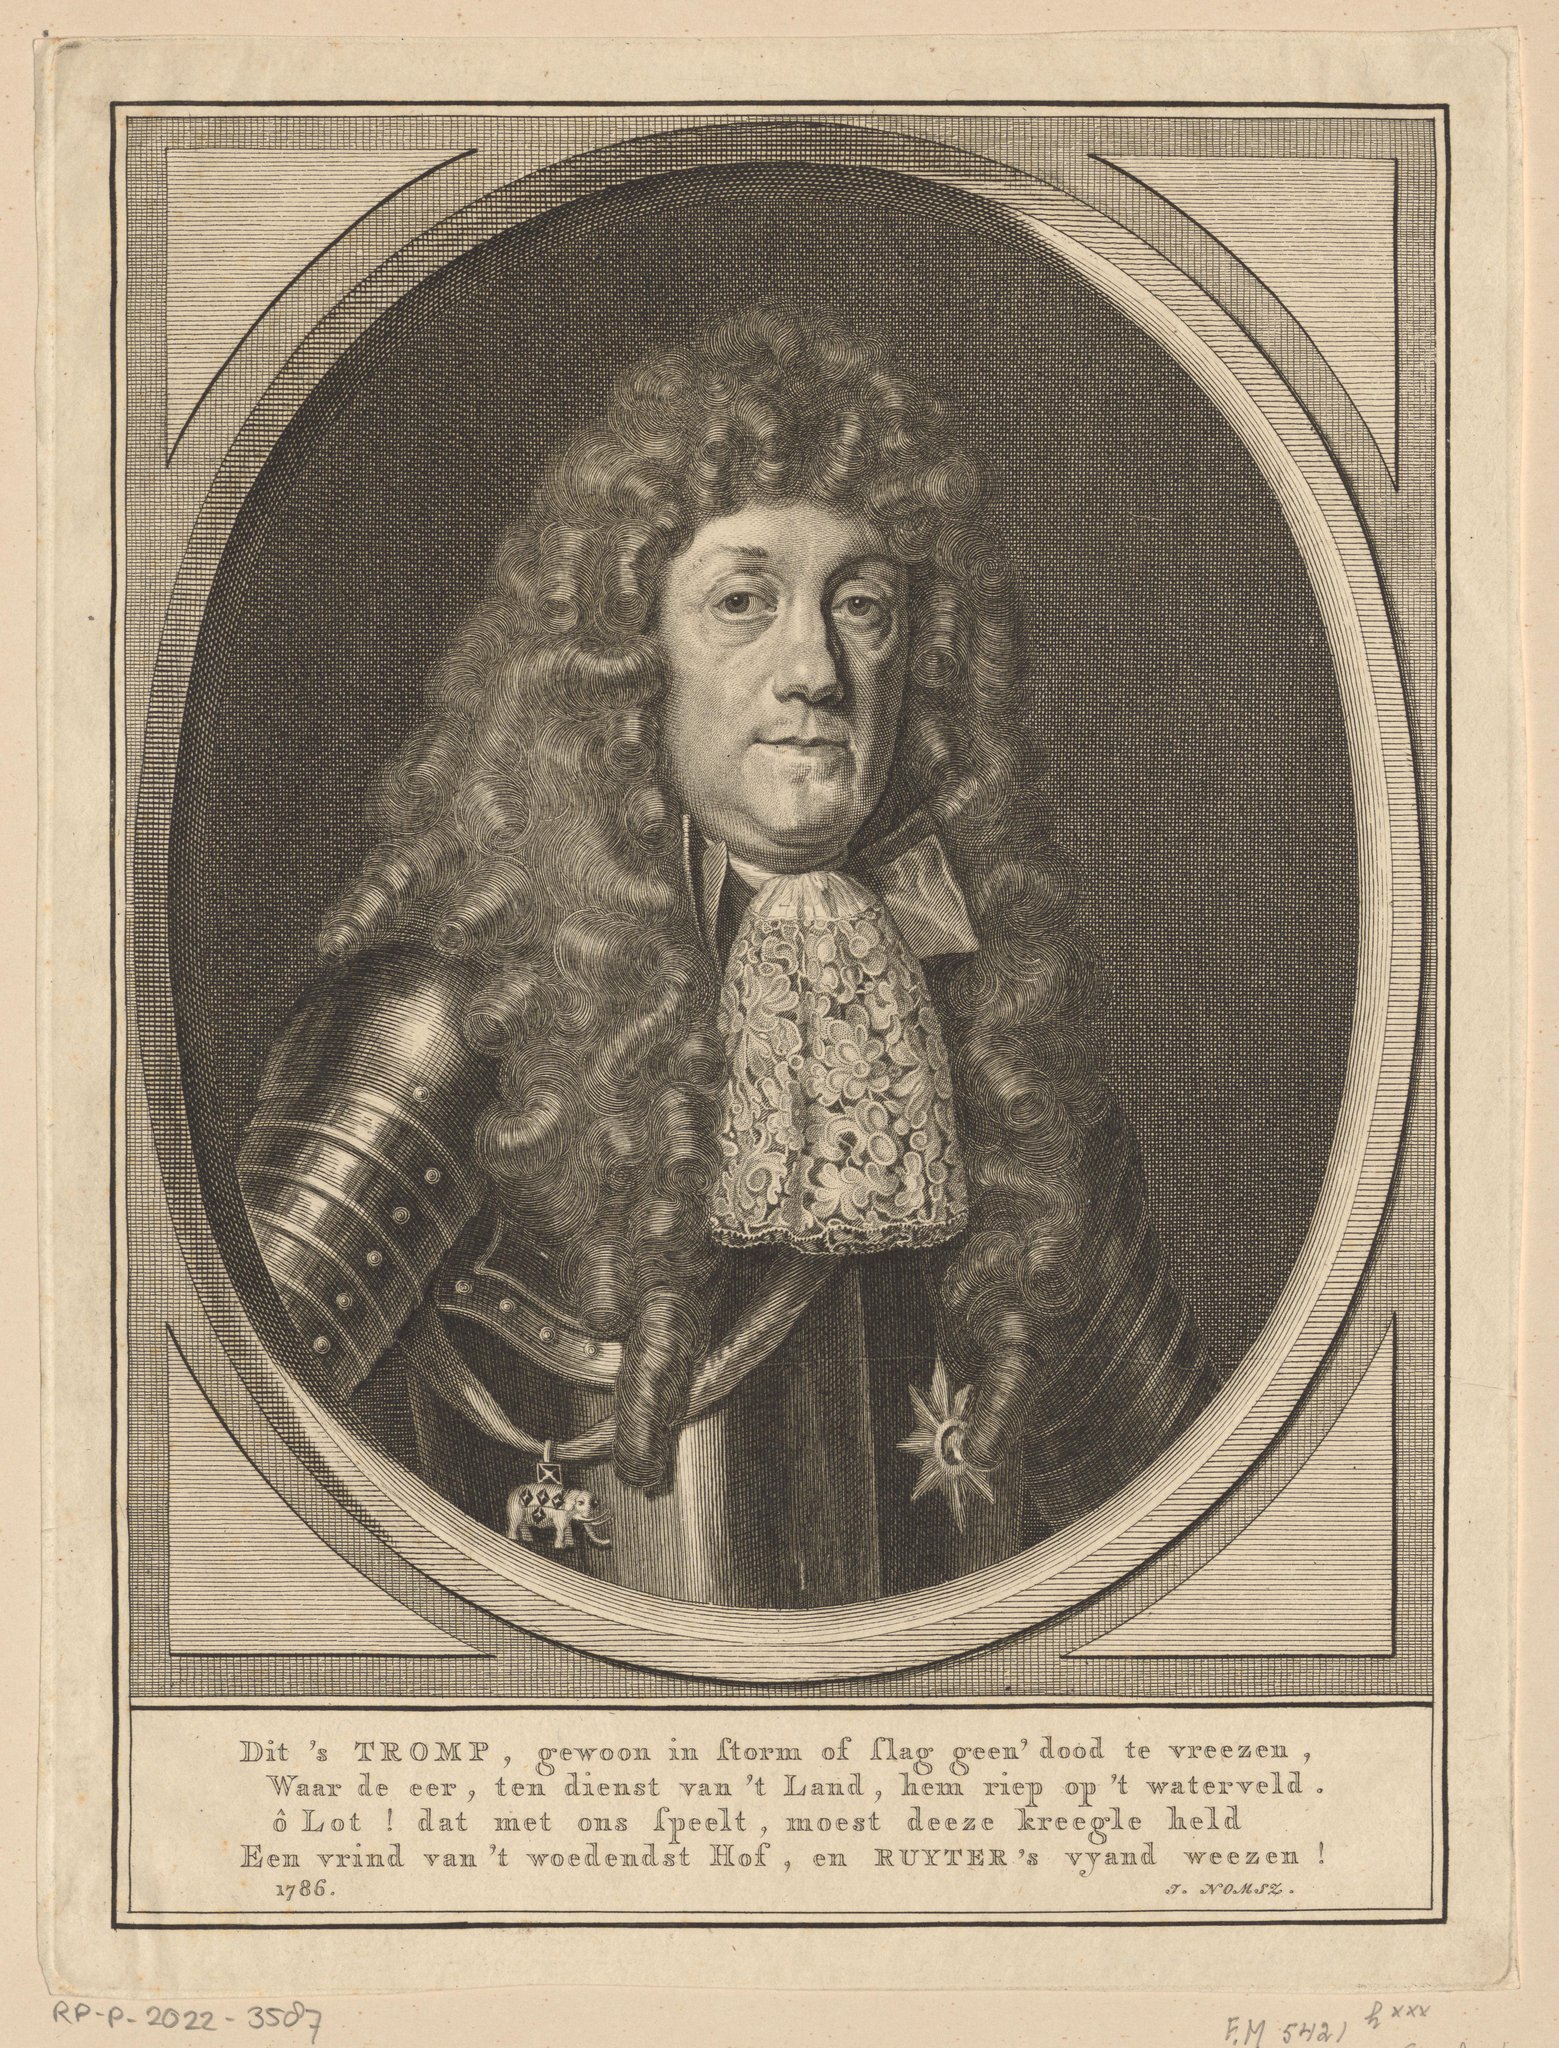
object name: print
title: Portret van Cornelis Tromp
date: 1786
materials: paper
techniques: engraving, etching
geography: northern netherlands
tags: rotterdam, amsterdam, cornelis tromp, armour, historical persons, commander-in-chief, admiral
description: Met vierregelig onderschrift in het Nederlands.